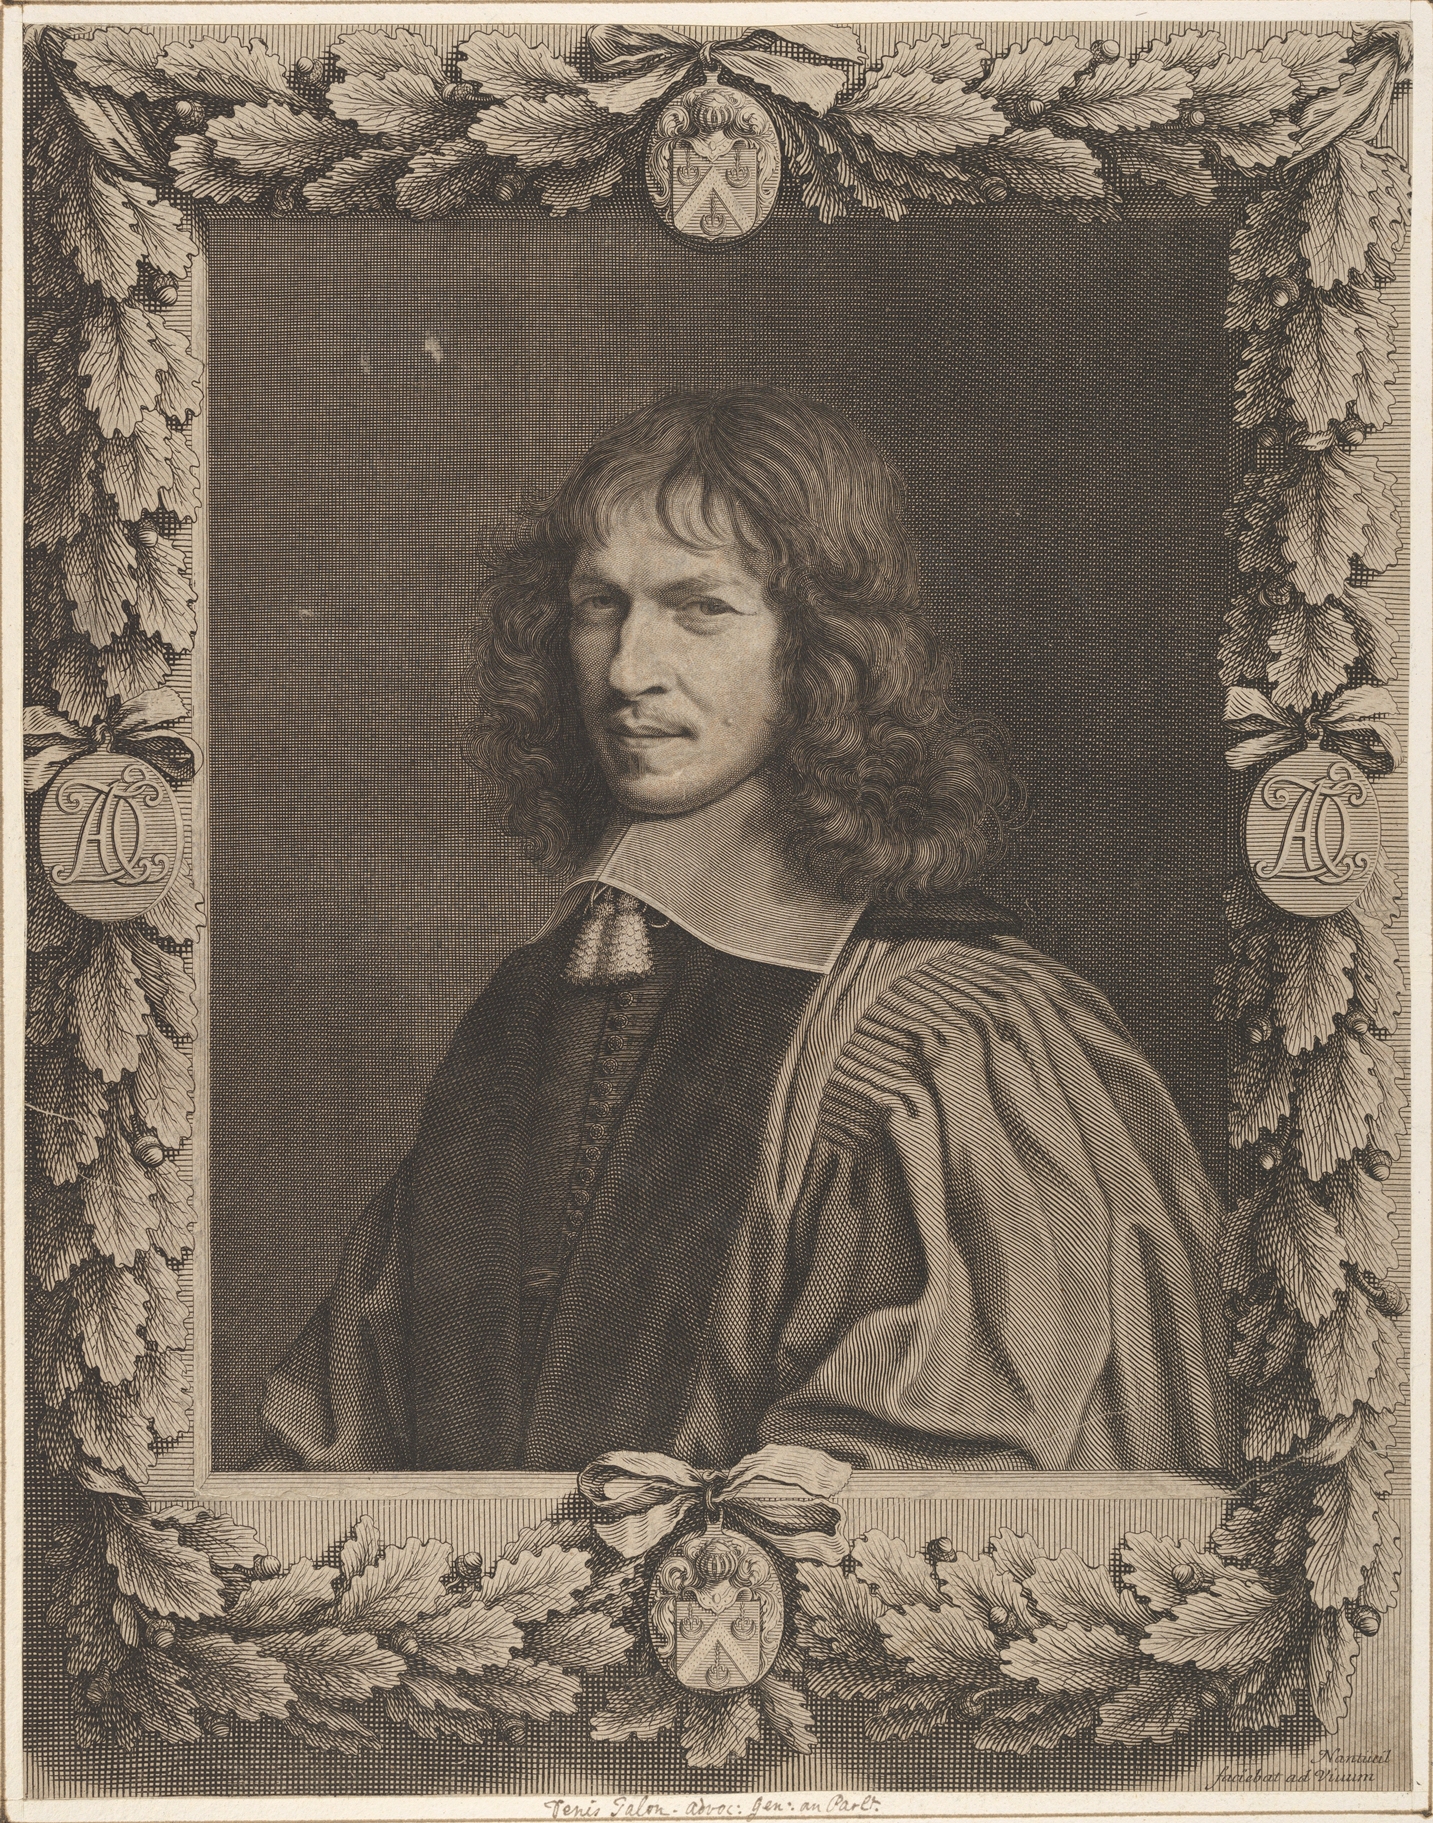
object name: print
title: Denis Talon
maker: robert nanteuil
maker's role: artist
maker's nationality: french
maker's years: 1623-1678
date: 1656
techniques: engraving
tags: men,portraits,coat of arms